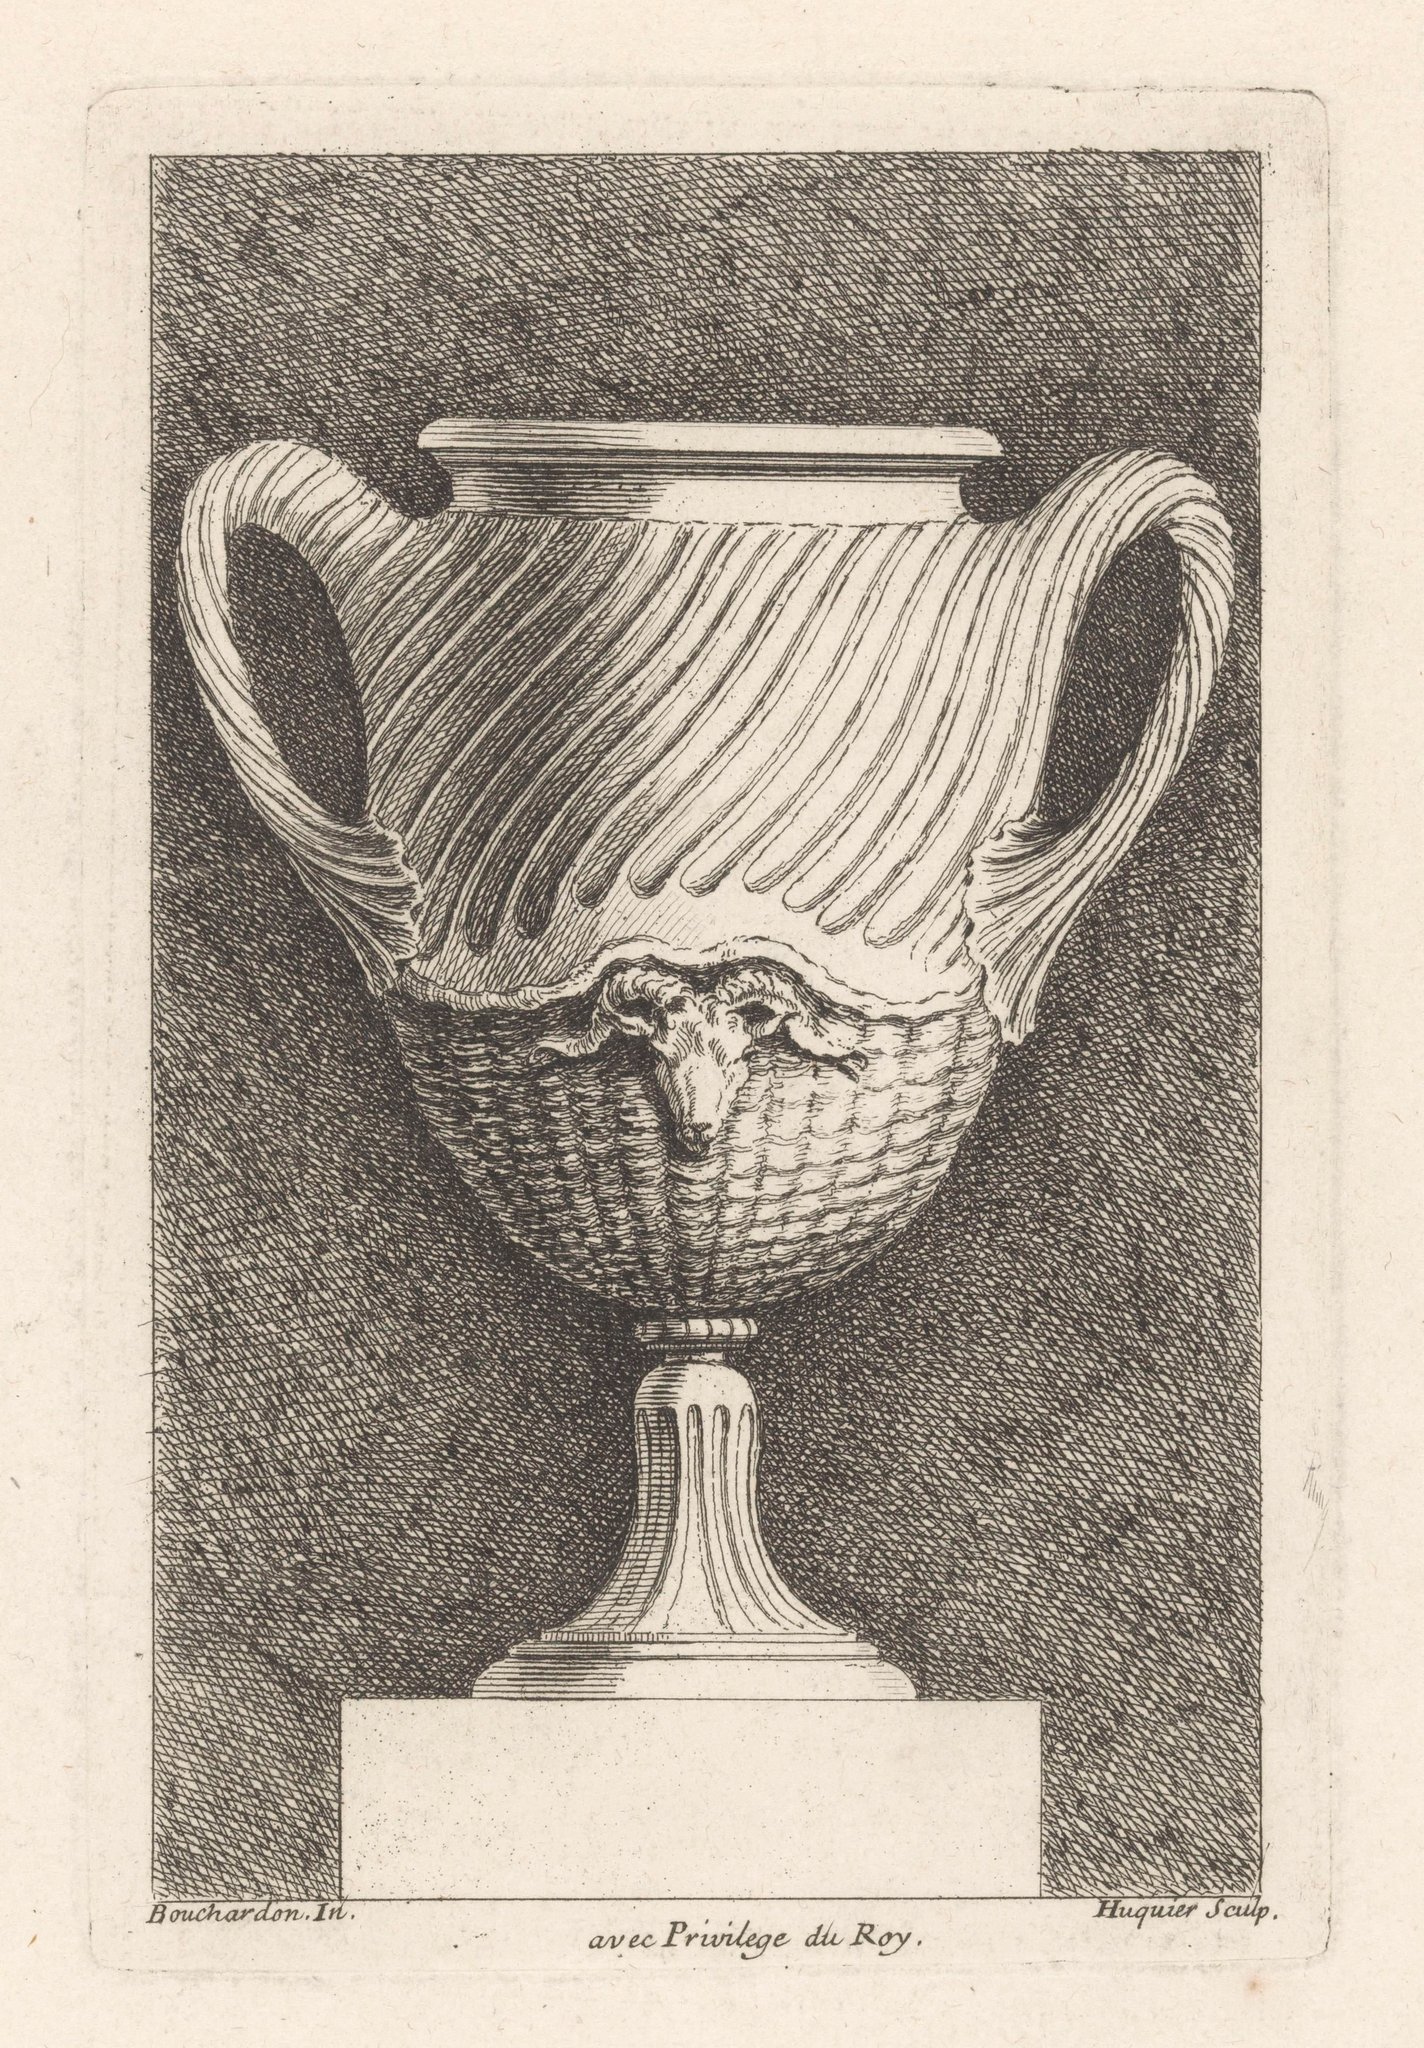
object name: ornament print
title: Premier livre de vases (...)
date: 1729-1737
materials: paper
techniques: etching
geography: paris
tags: ram's head ~ ornament, vase ~ ornament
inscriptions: collector's mark: Lugt 2228